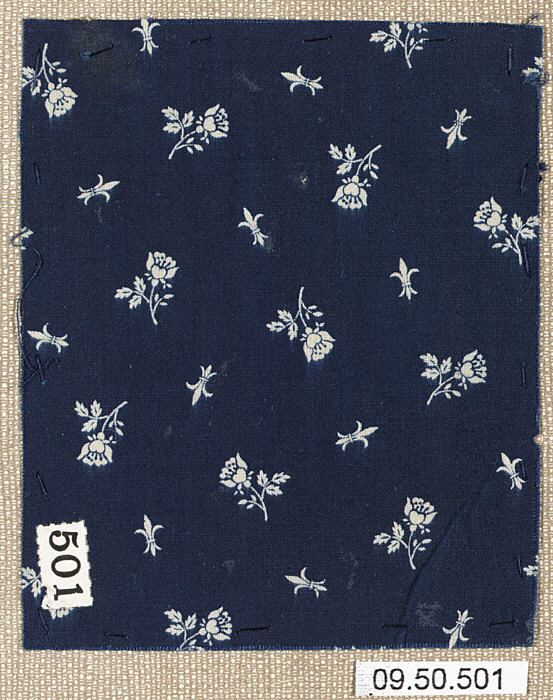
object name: piece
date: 1801-1900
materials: cotton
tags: flowers,leaves